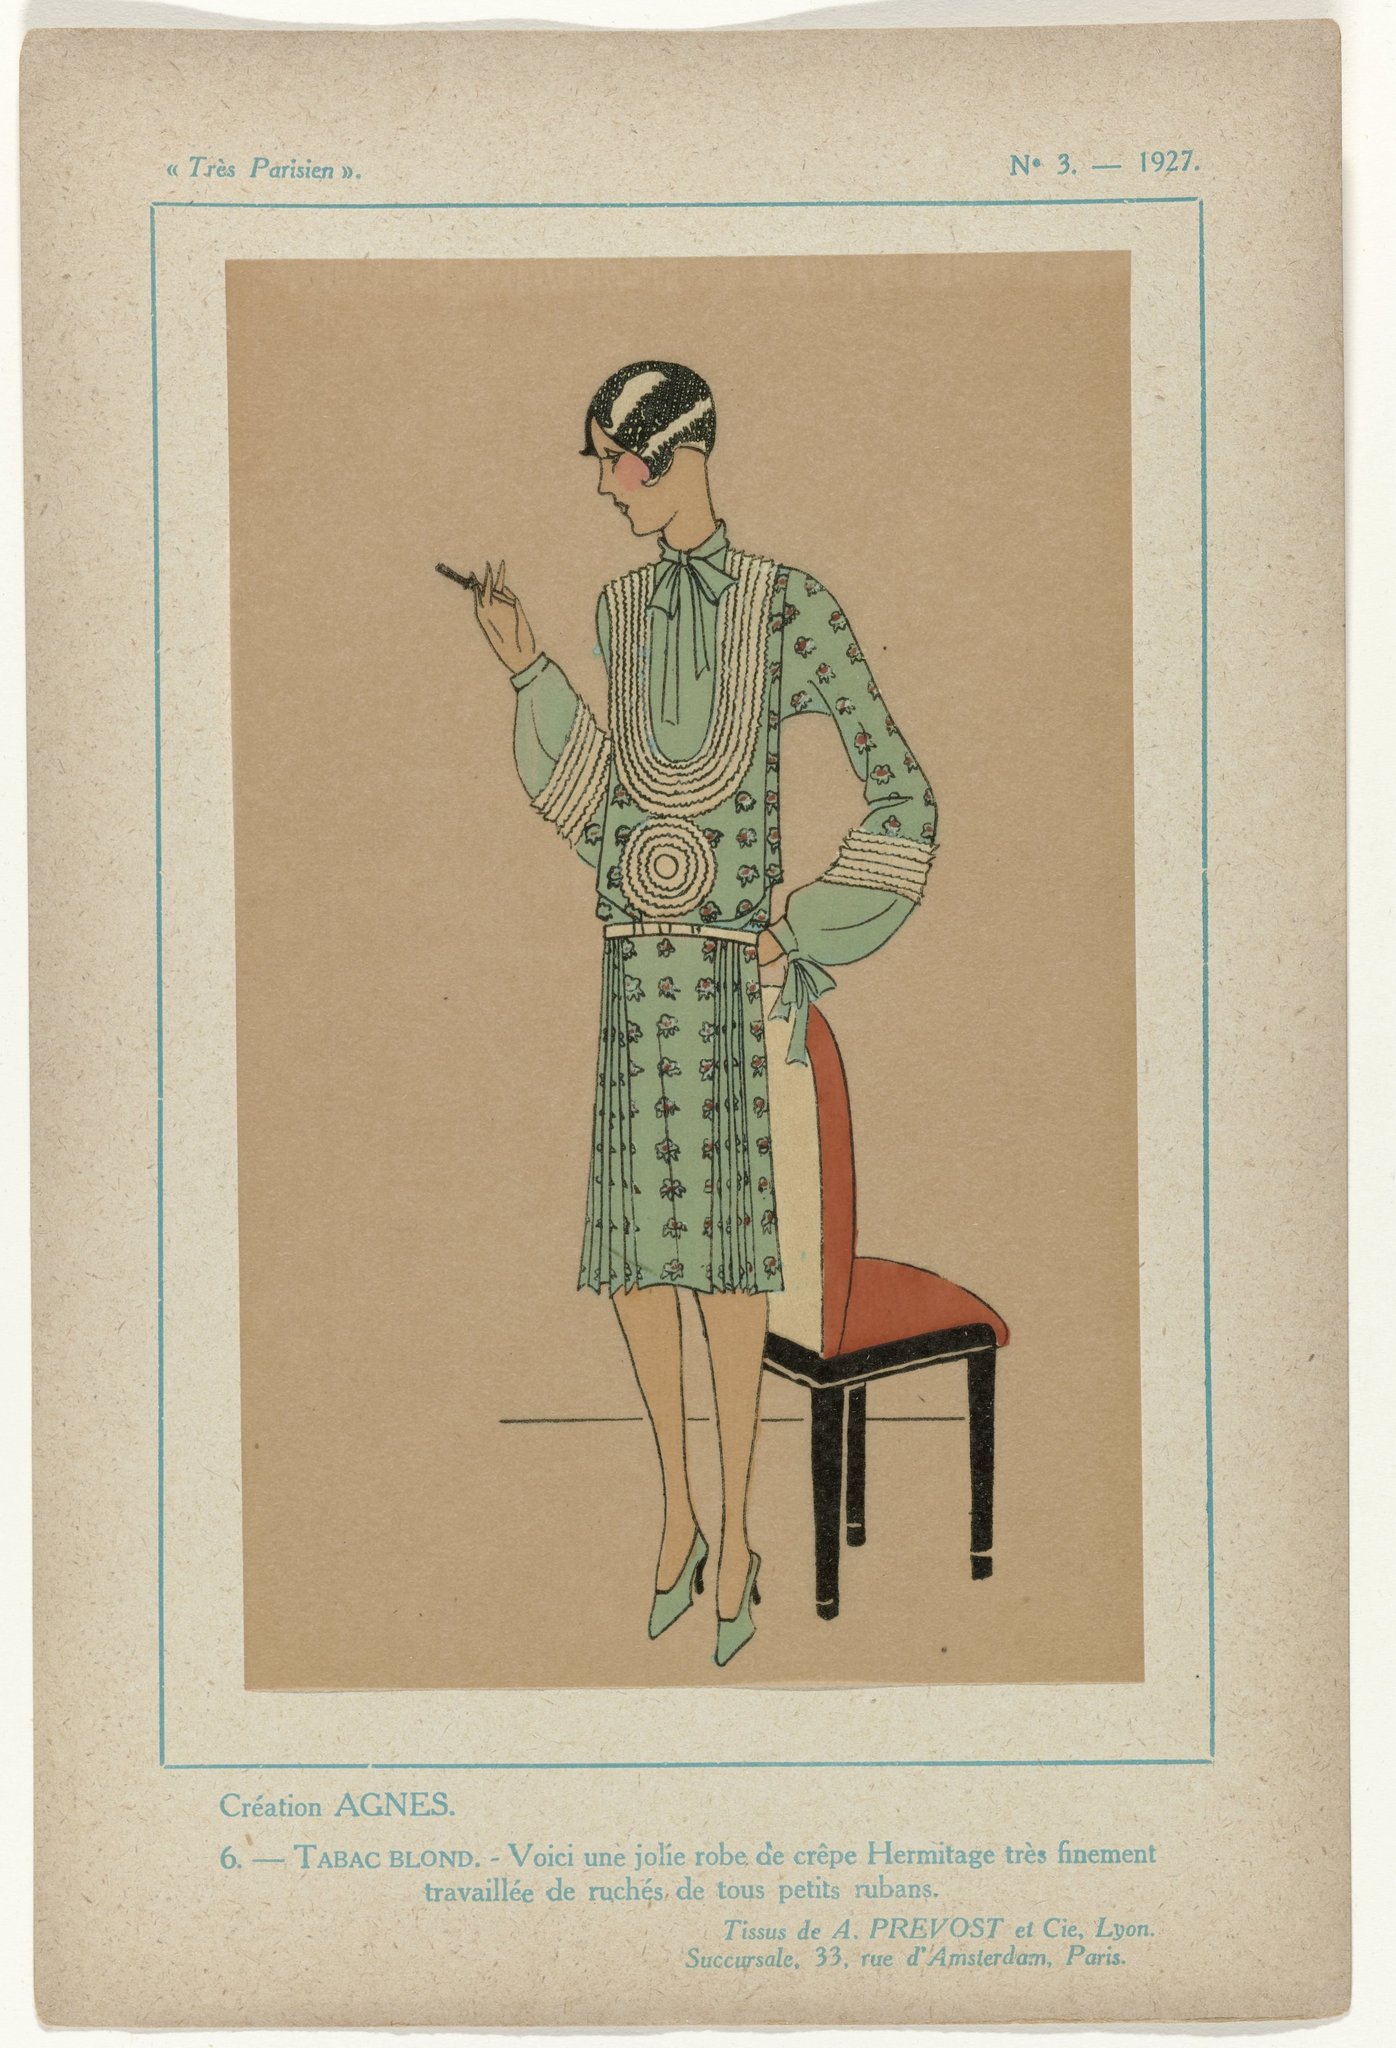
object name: fashion print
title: Très Parisien, 1927 No. 3, Pl. 6: Création AGNES - TABAC BLOND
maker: g-p. joumard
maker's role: publisher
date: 1927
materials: paper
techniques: hand coloring, letterpress printing, lithography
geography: paris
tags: cigarette, dress, gown: day dress (+ women's clothes), fashion plates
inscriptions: caption: ‘TABAC BLOND. - Voici une jolie robe de crêpe Hermitage très finement travaillée de ruchés de tous petits rubans.’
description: Rokende jonge vrouw in japon van crêpe 'Hermitage', met ruches. Stof van A. Prévost et Cie, Lyon. Prent uit het modetijdschrift Très Parisien...La Mode, Le Chic, L'Élégance (1920-1936)